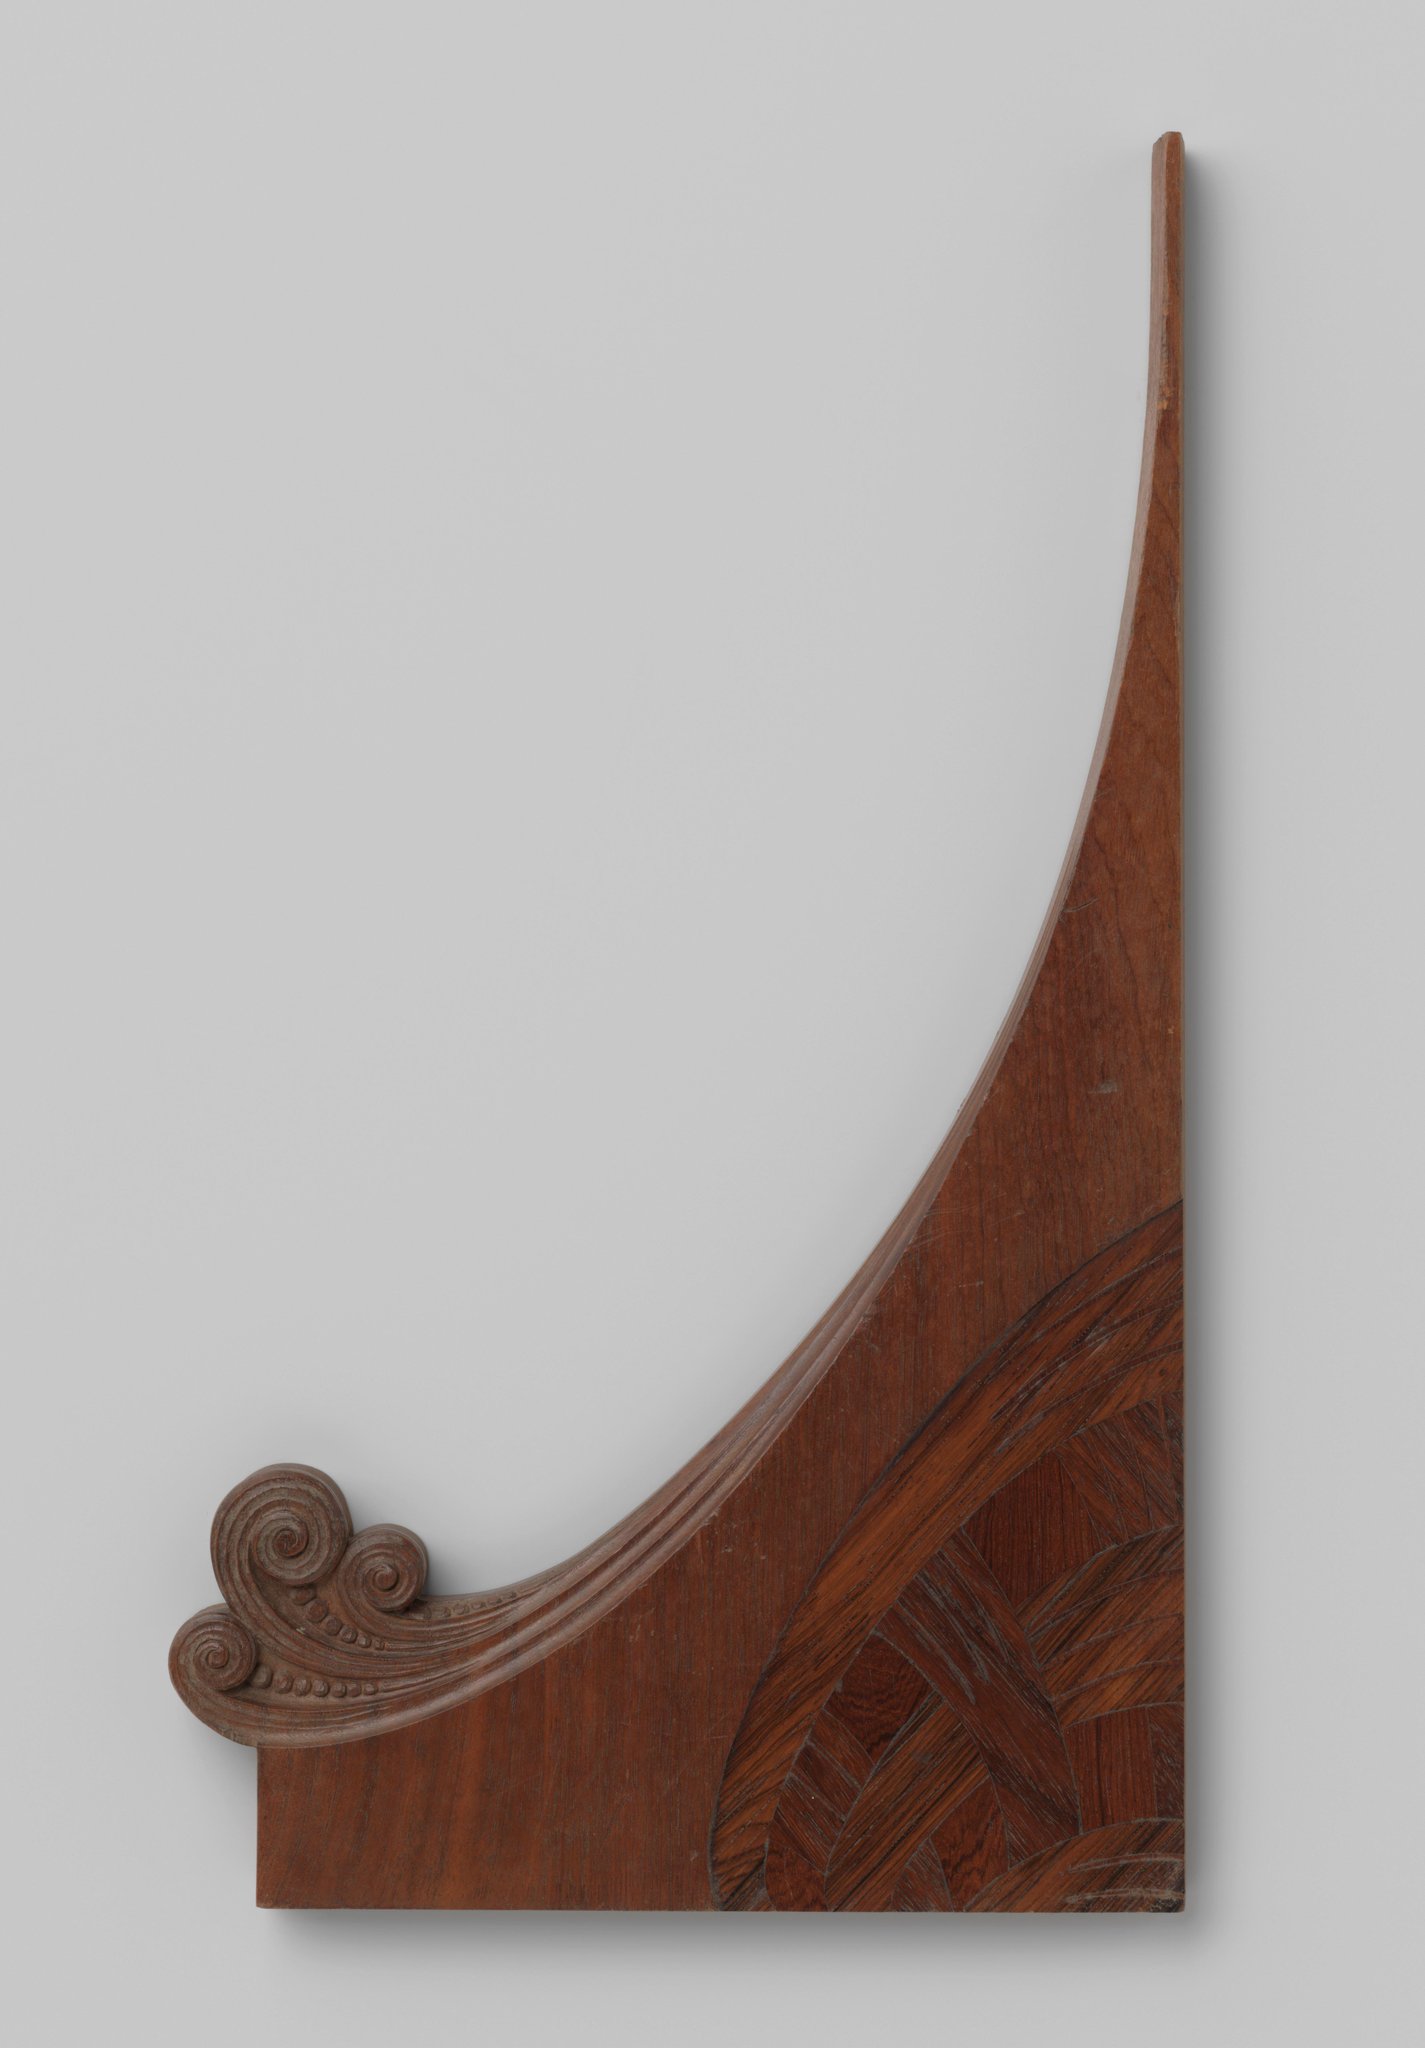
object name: betimmering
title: Hoekstuk van een lambrizering, onderdeel van een betimmering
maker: napoleon le grand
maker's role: furniture worker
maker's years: 1857-1932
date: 1900-1905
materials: wood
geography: netherlands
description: Hoekstuk van een lambrizering, onderdeel van een betimmering, uitgevoerd in noten, triplex, diverse houtsoorten.